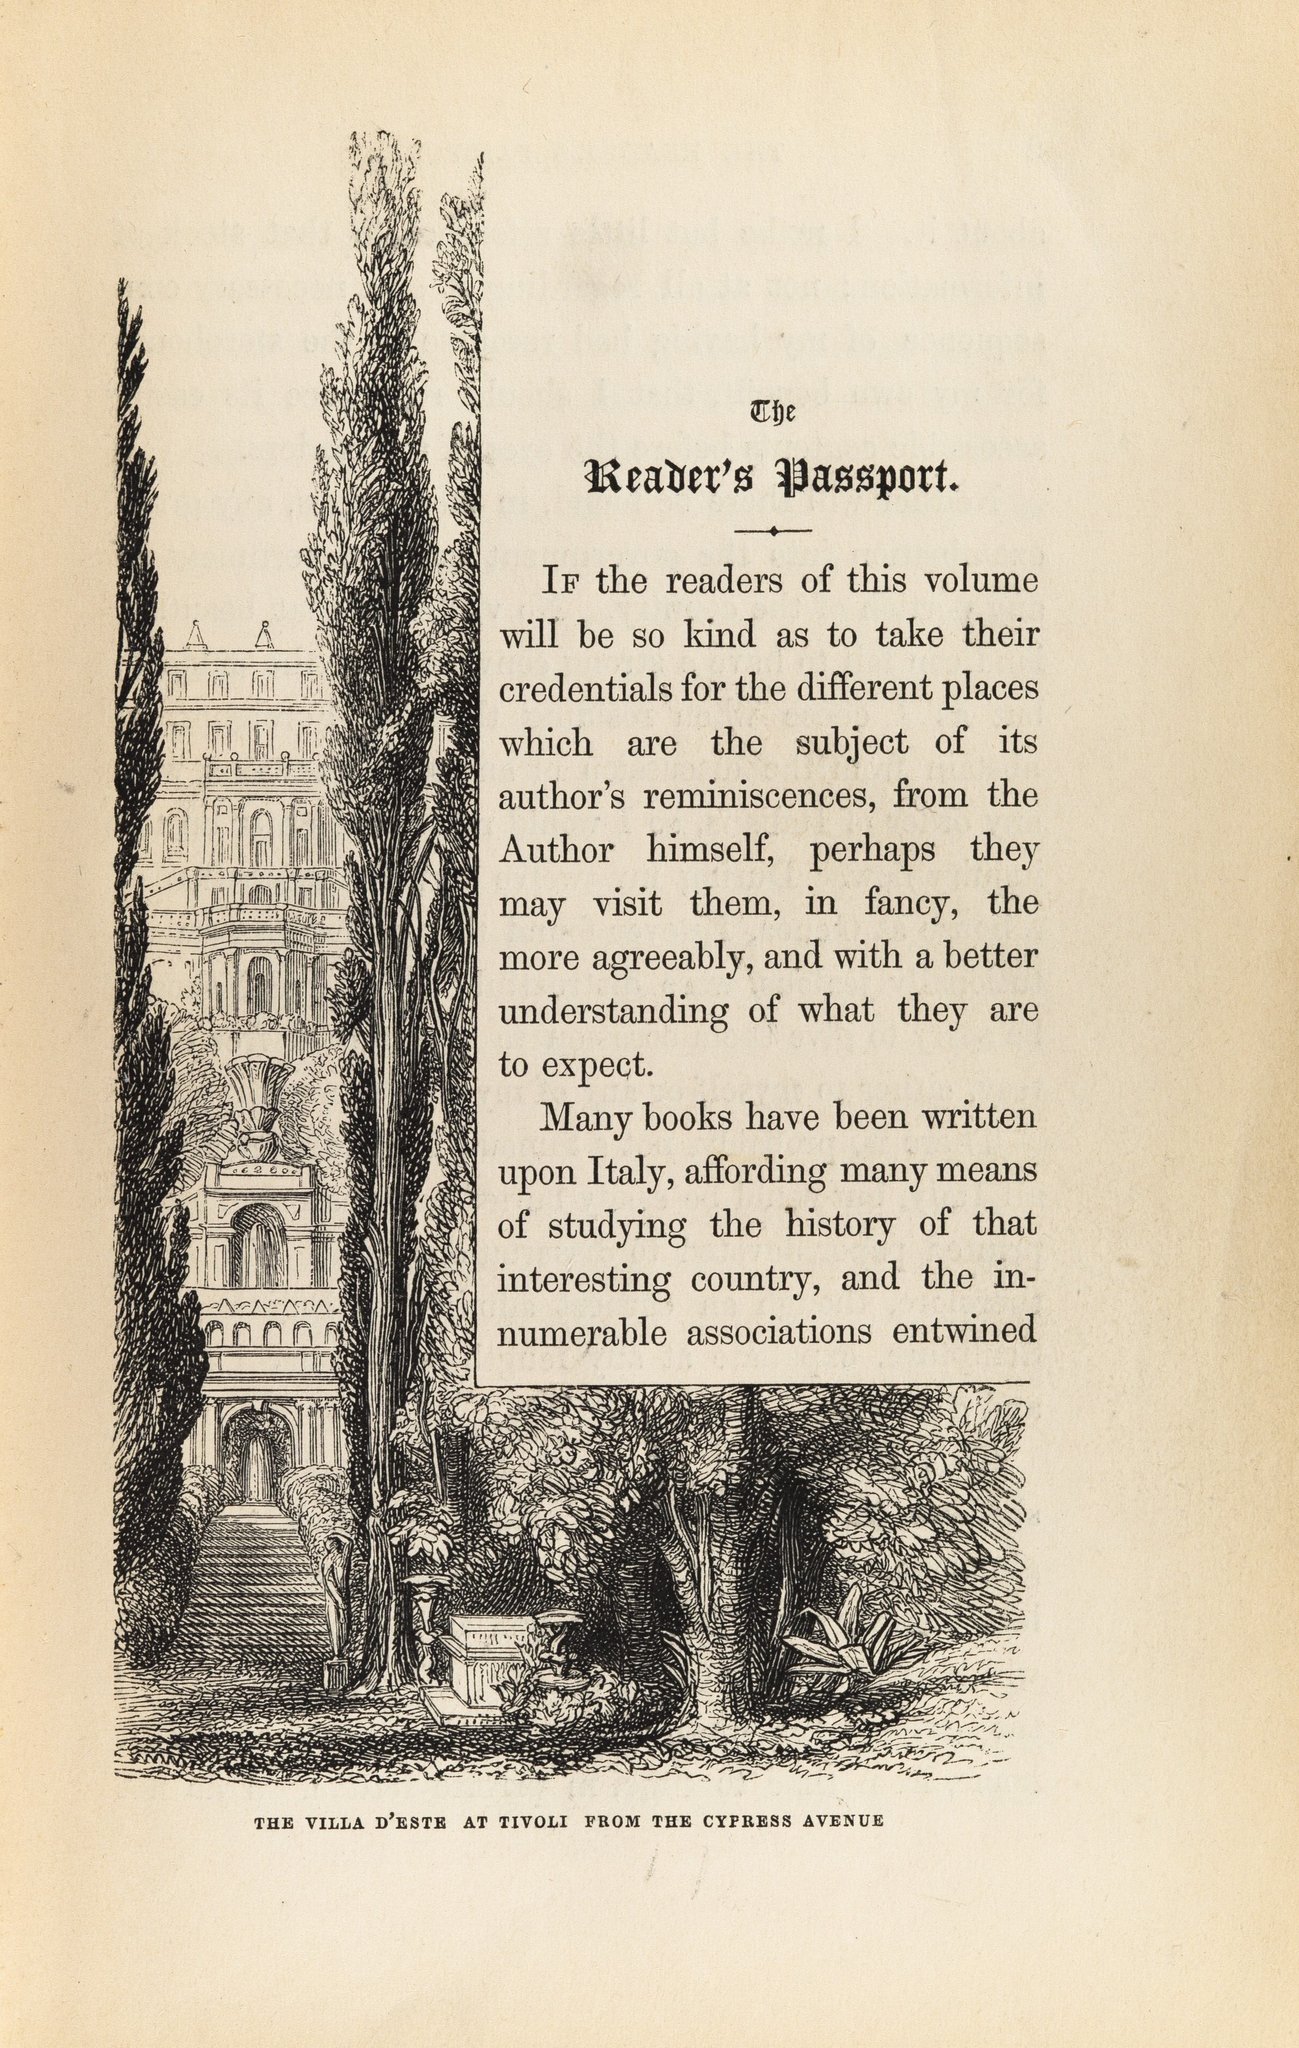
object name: book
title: Pictures from Italy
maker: charles dickens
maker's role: author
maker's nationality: british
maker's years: 1812-1870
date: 1846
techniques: engraving